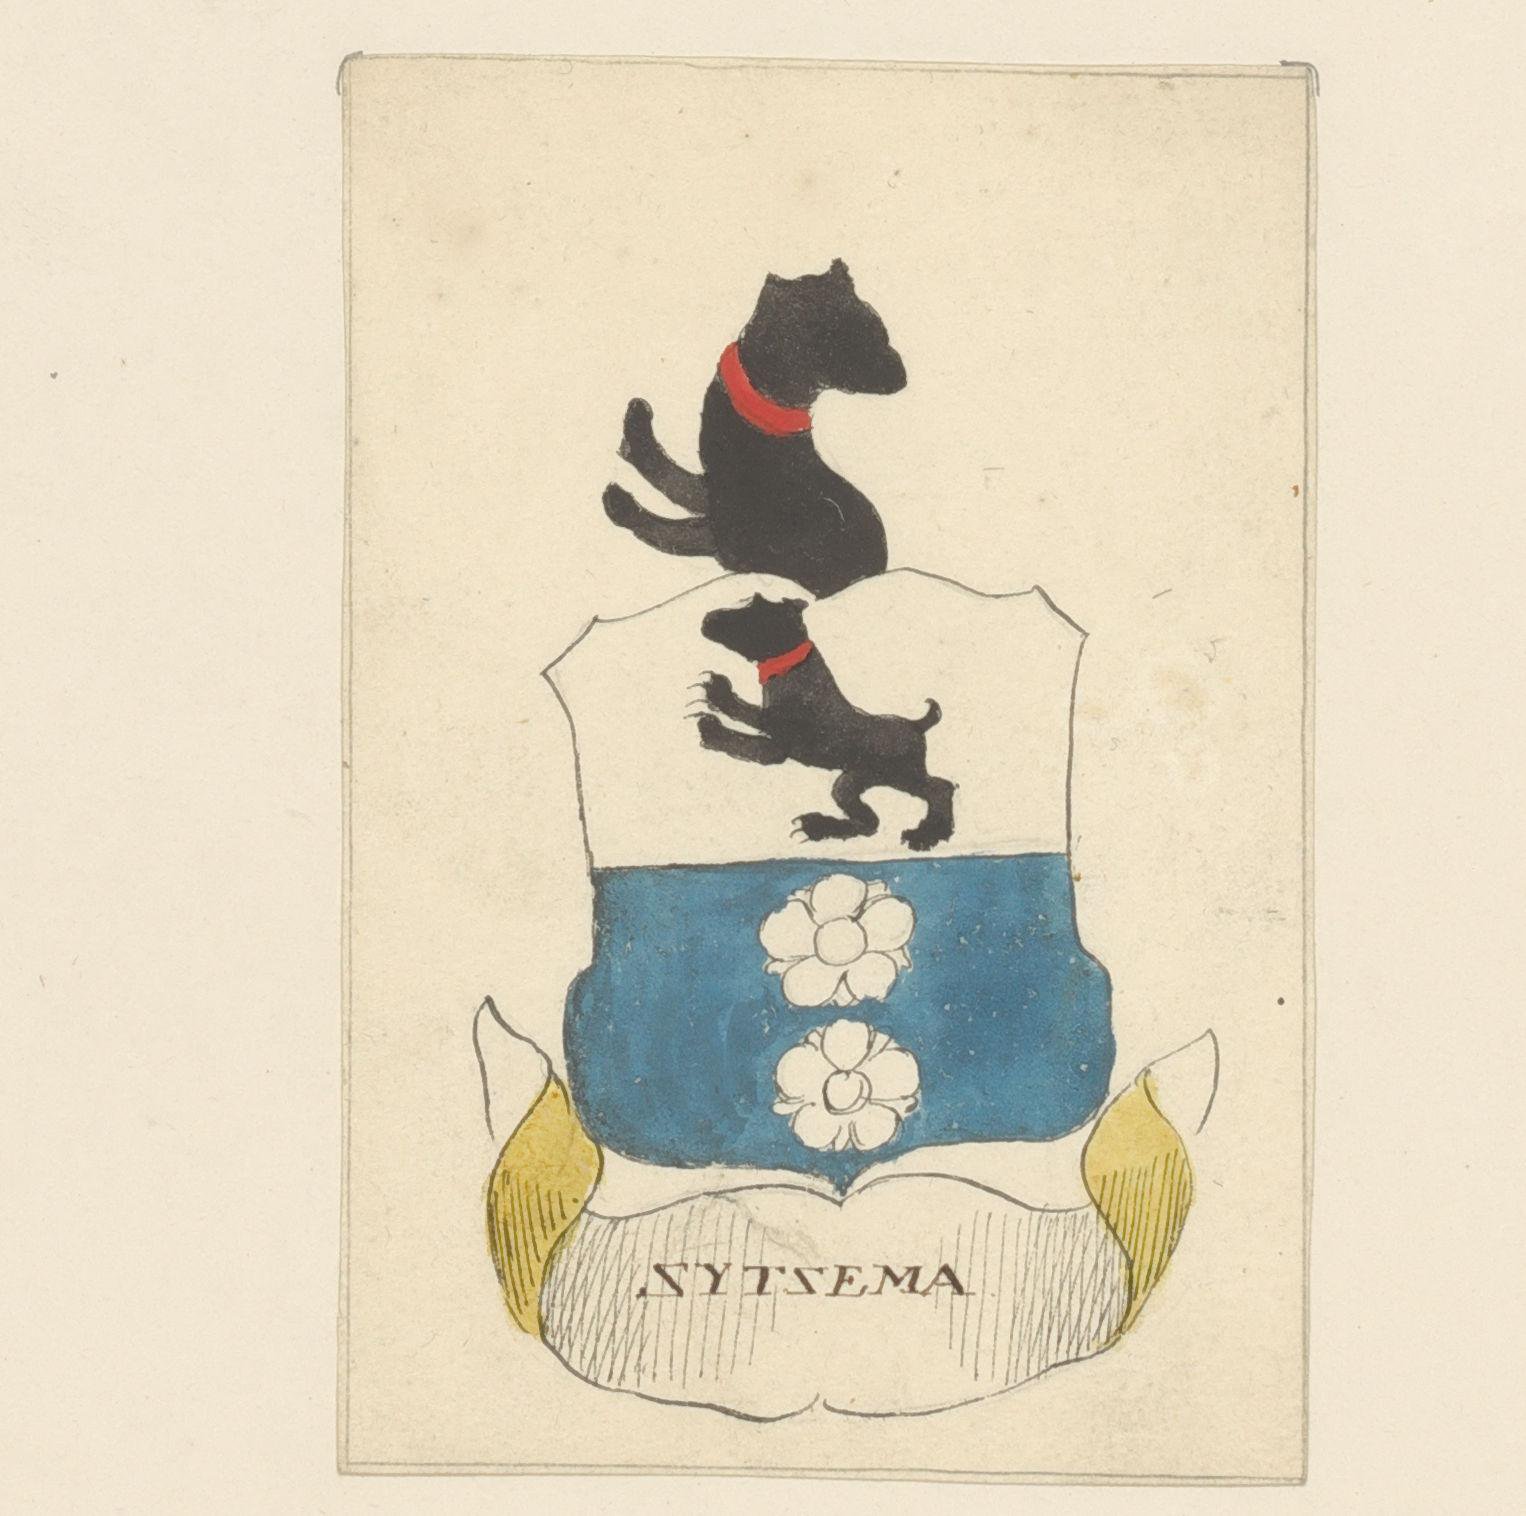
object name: drawing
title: Sytsema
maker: Anonymous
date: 1850-1950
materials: ink, paper, watercolor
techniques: brush, pen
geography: netherlands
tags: armorial bearing, heraldry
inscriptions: collector's mark: Lugt 1641, collector's mark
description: Familiewapen van Sytsema. Onderwerpsrubrieken binnen de Atlas Zeden en Gewoonten: Regeering, Wapens (Heraldiek), Geslachtswapens.